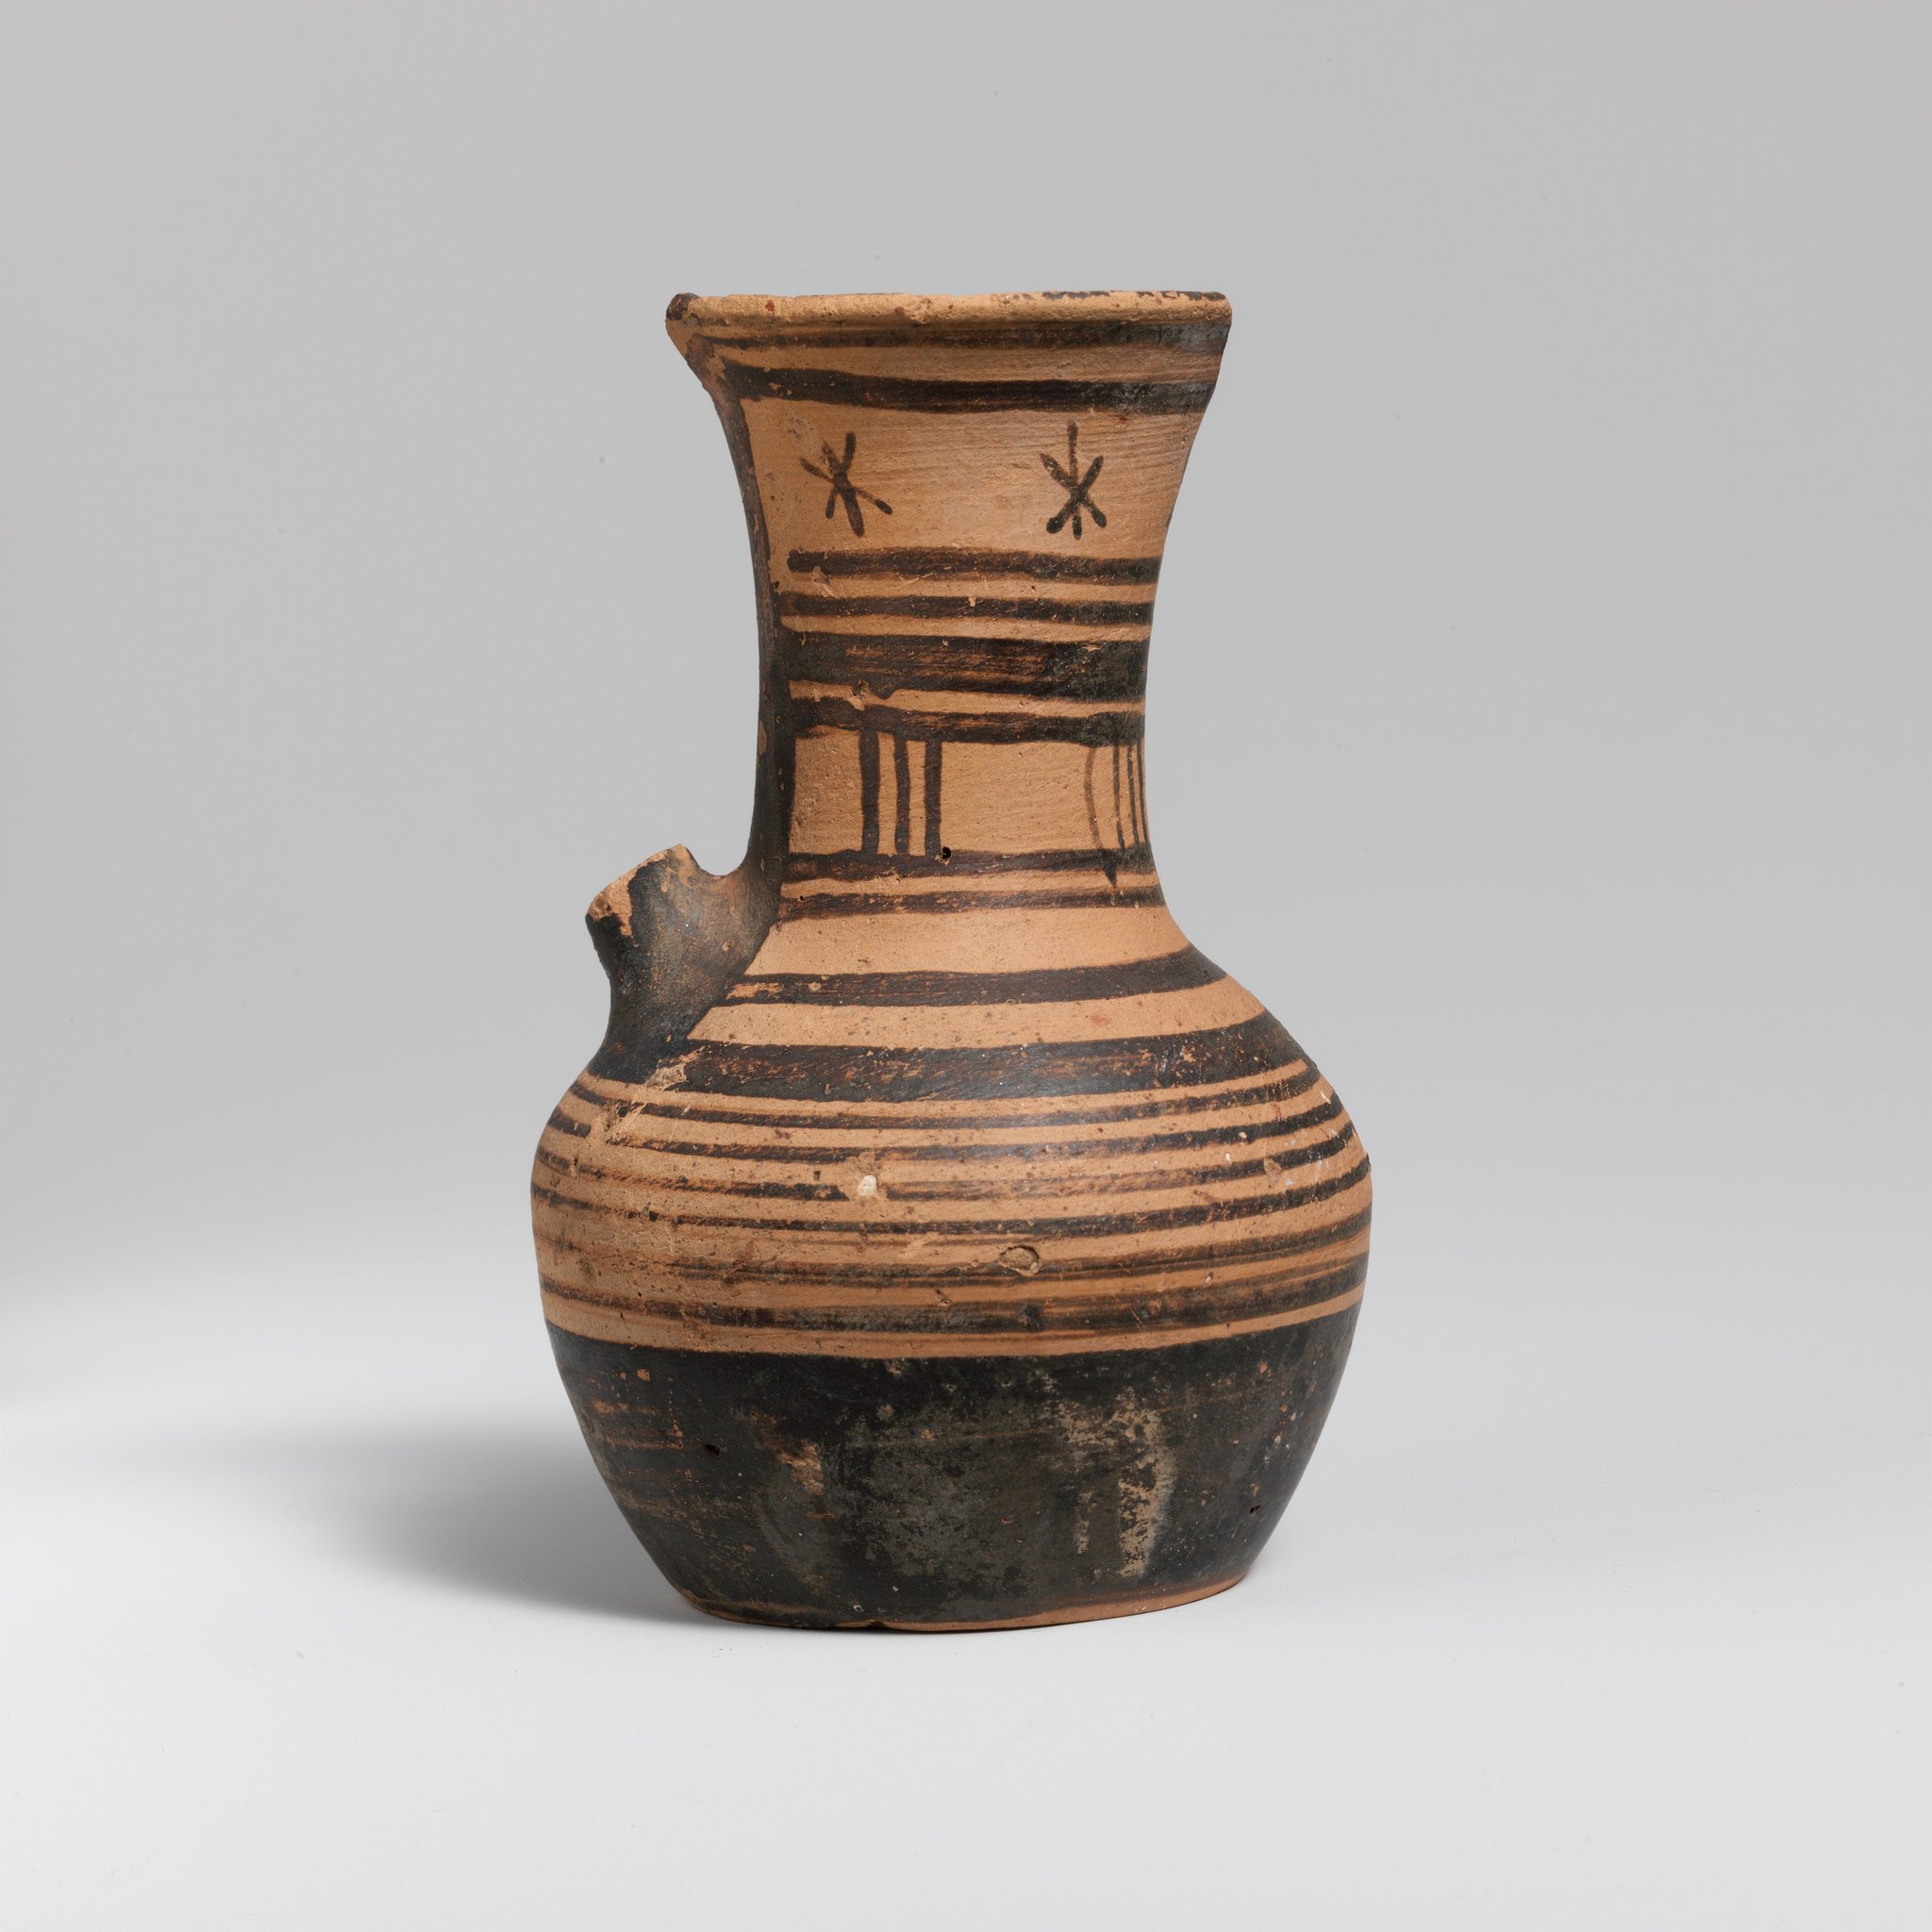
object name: oinochoe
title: Terracotta oinochoe (jug)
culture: greek, attic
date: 734-668 BCE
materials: terracotta